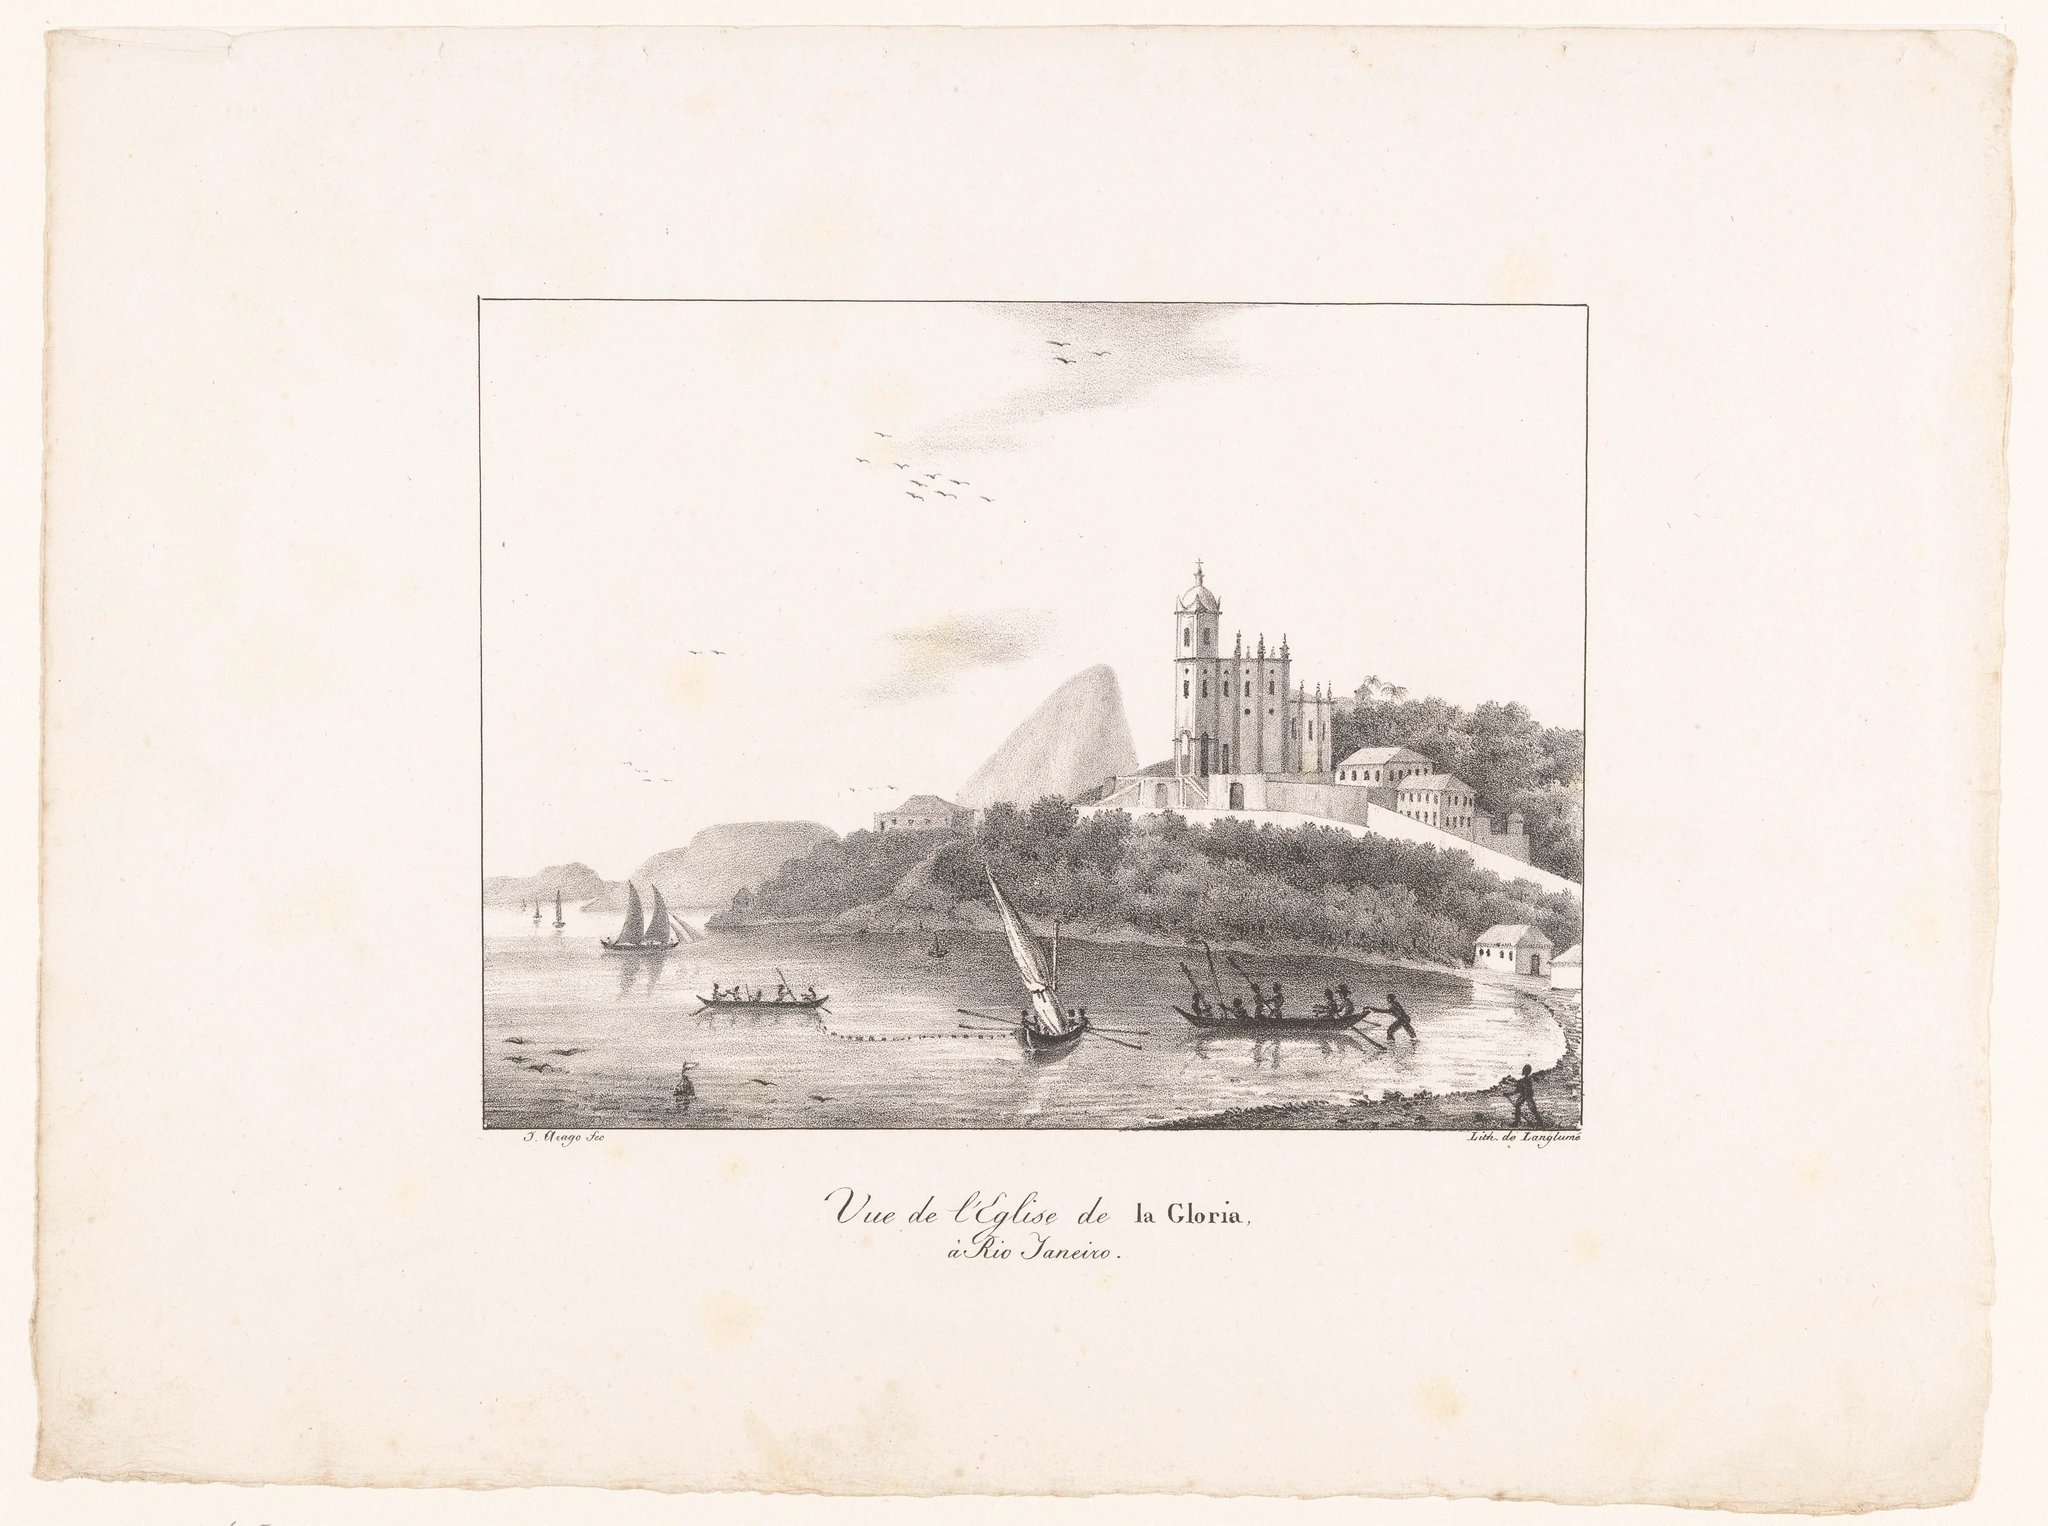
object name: book illustration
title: Vue de l'Eglise de la Gloria, à Rio Janeiro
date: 1822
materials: paper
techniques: lithograph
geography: paris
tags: gulf, bay, sailing-ship, sailing-boat, church (exterior), rowing-boat, canoe, etc.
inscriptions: collector's mark: Lugt 2228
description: Prent mogelijk uit een album dat is uitgegeven bij: Arago, J.E.V. Promenade autour de monde pendant les années 1817, 1818, 1819 et 1820, sur les corvettes du roi l'Uranie et la Physicienne, commandées par M. Freycinet. 2 dln. Parijs: Leblanc, 1822.